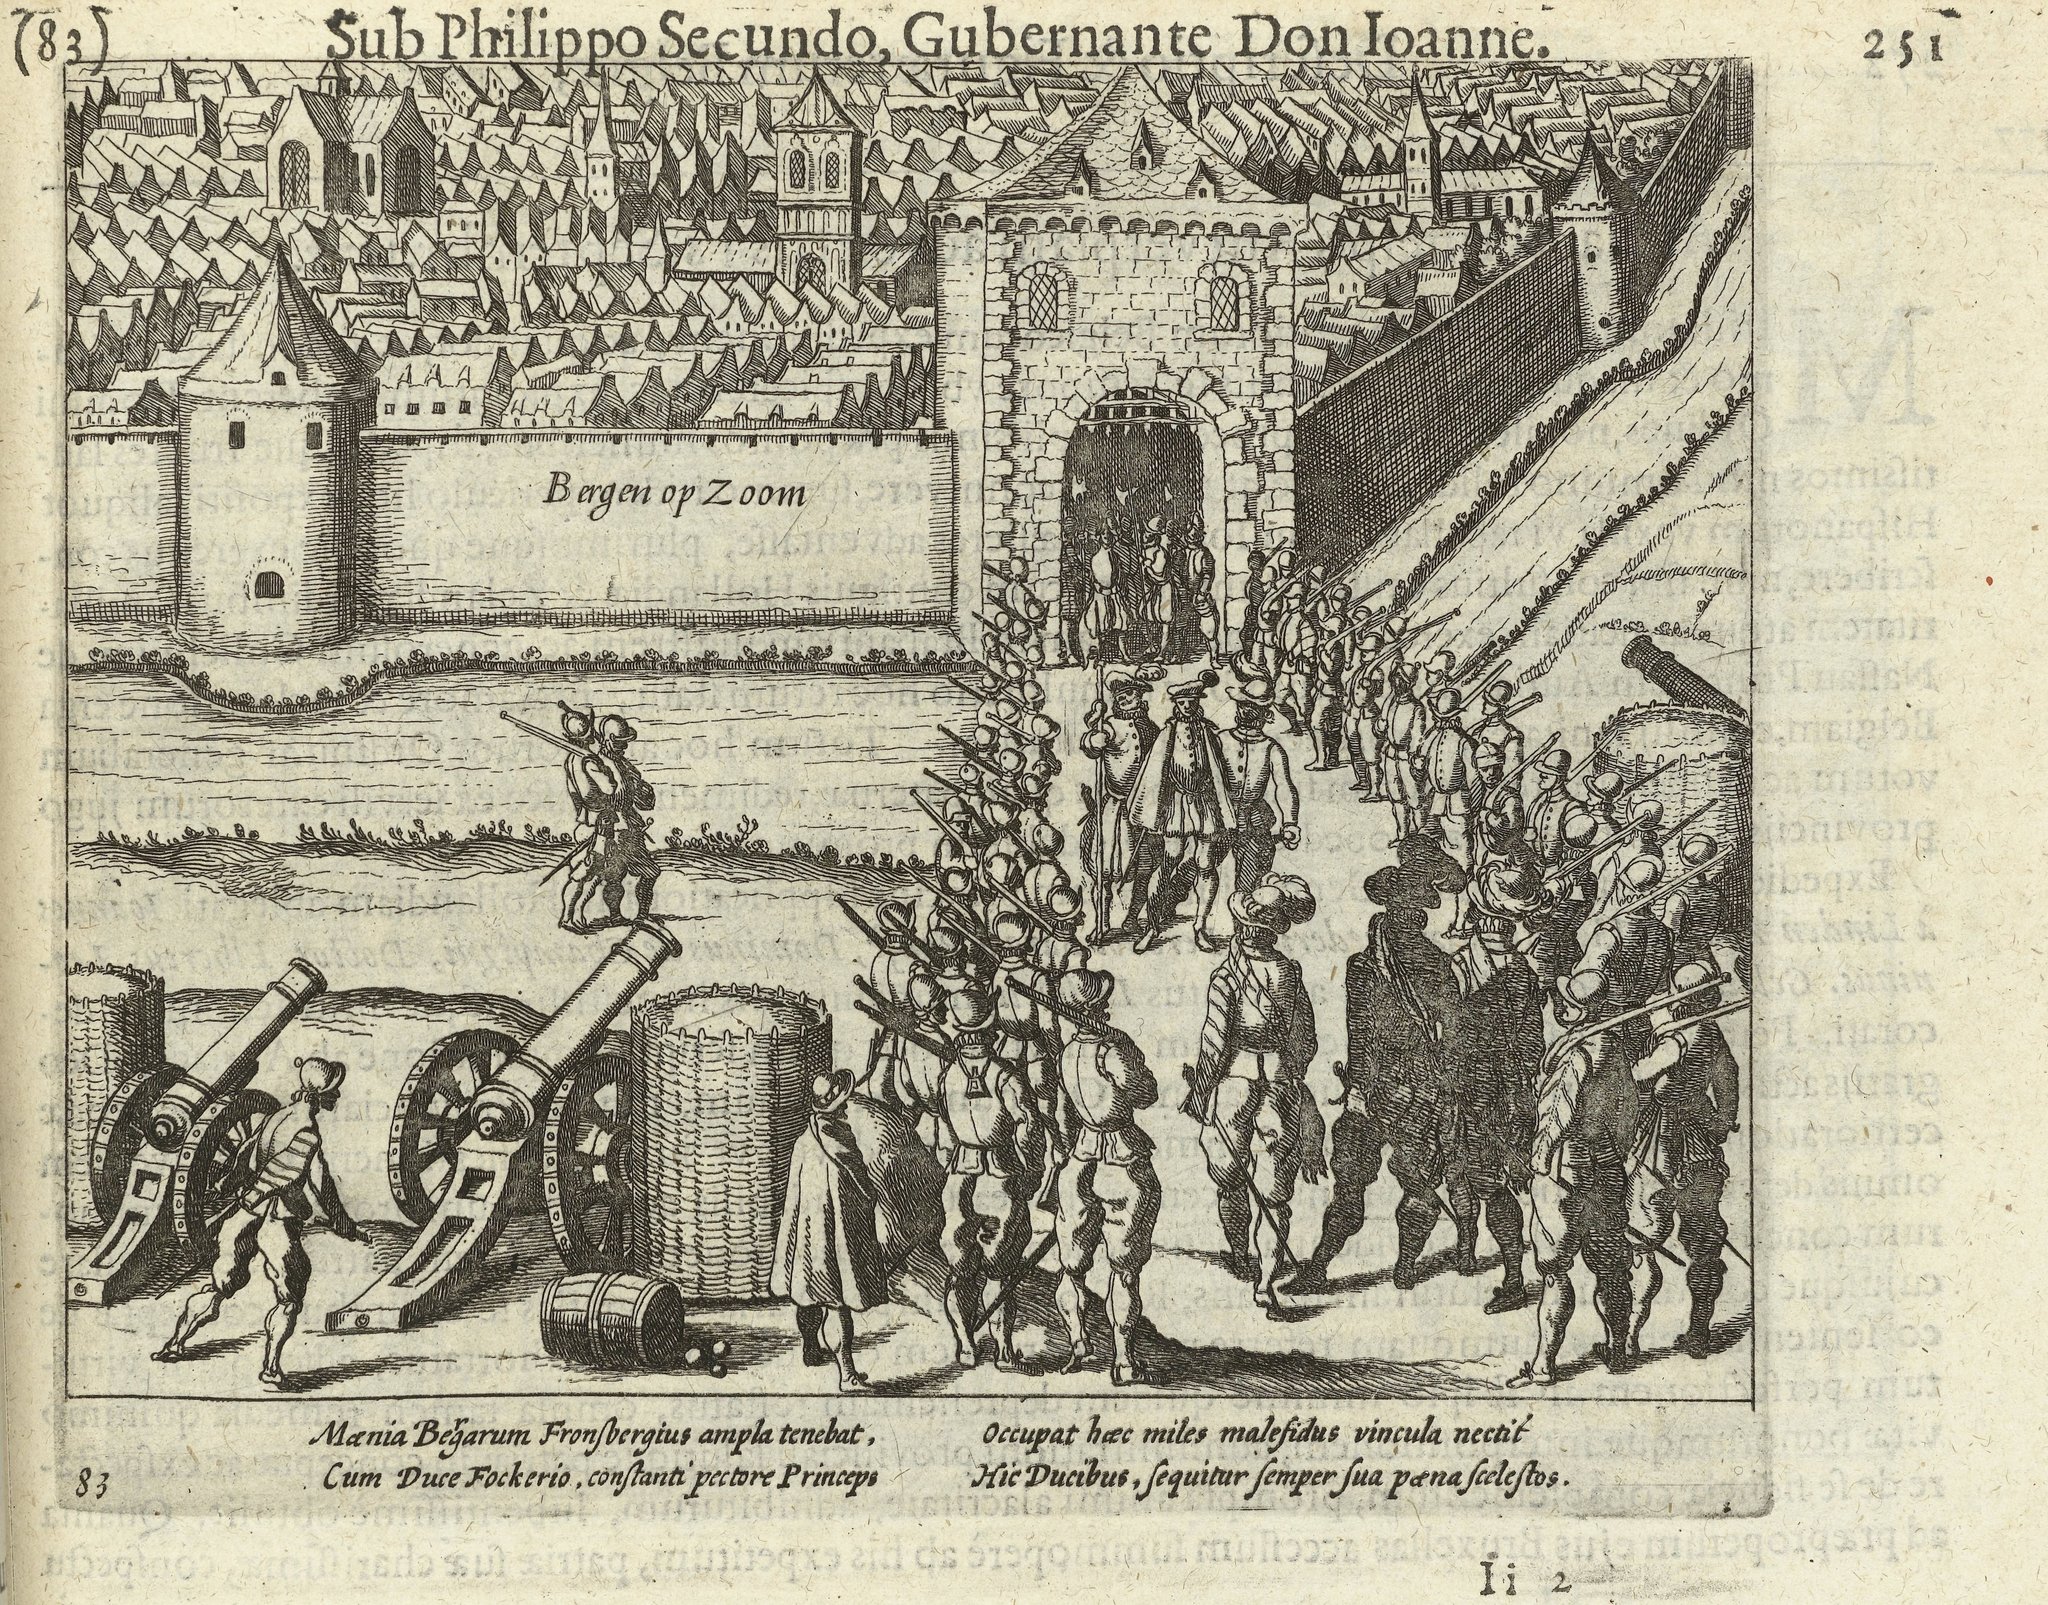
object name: history print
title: Carl Fugger en Fronsberger gevangen genomen voor Bergen op Zoom, 1577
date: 1613-1615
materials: paper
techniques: etching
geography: amsterdam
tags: augsburg, bergen op zoom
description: De Duitse legeraanvoerders Carl Fugger (Focker) en Fronsberger worden door de magistraat van Bergen op Zoom uitgeleverd aan het Staatse leger onder Champagney, 13 september 1577. Met onderschrift van 4 regels in het Latijn. Genummerd: 83. Bedrukt op achterzijde met tekst in het Latijn.